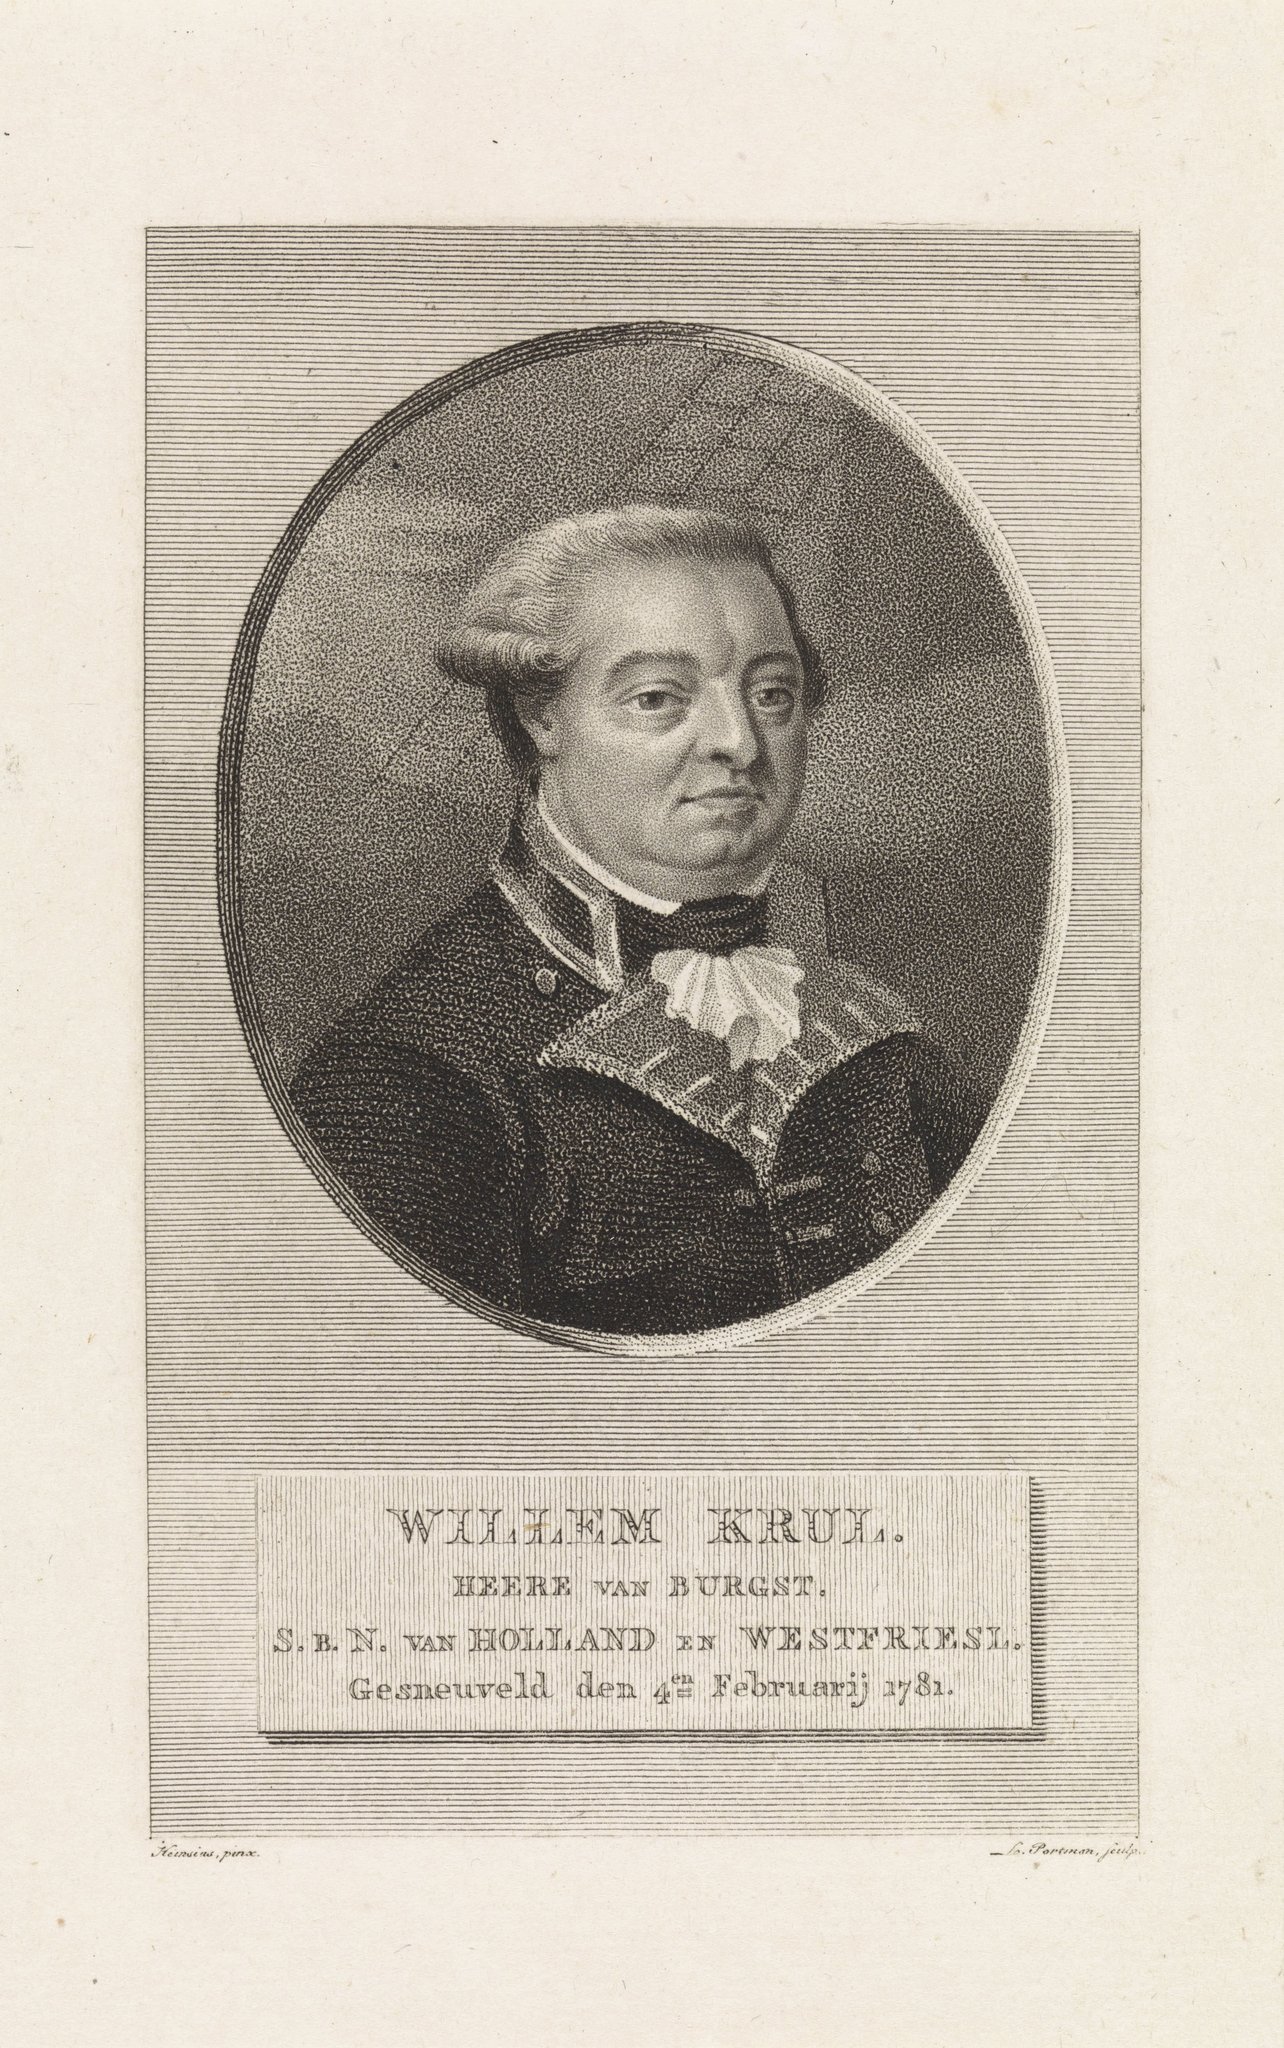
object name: print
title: Portret van Willem Crul, schout-bij-nacht van Holland en West-Friesland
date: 1787-1828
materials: paper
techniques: stippled etching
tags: haarlem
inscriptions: collector's mark: Lugt 2228